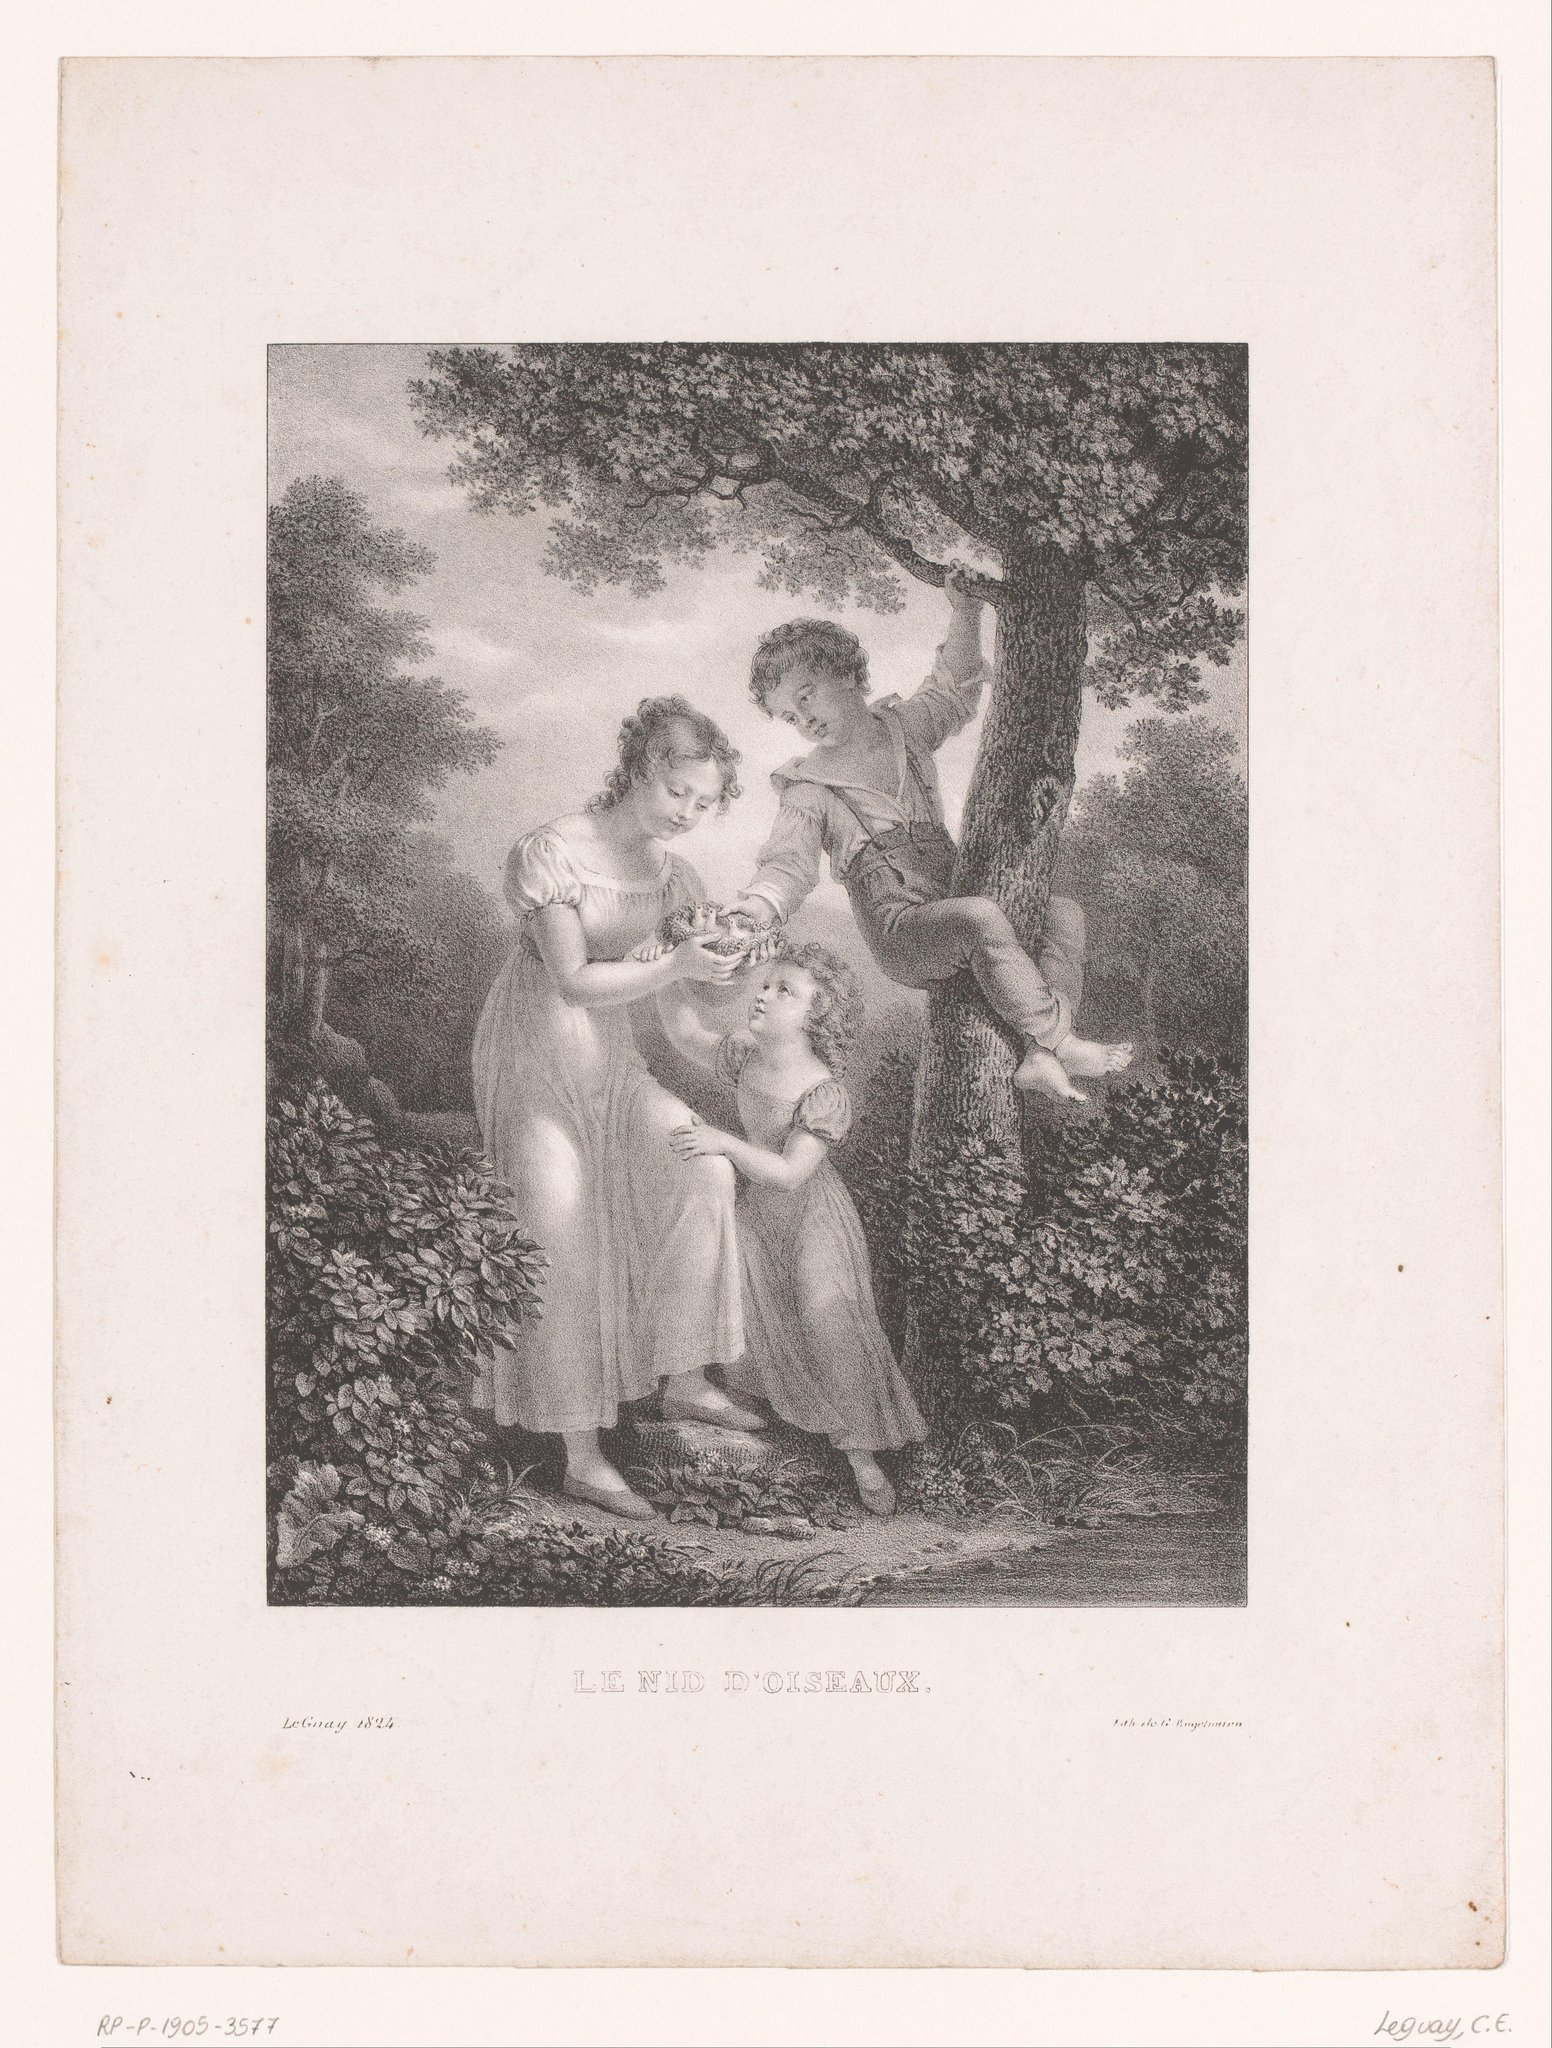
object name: print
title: Drie kinderen met een vogelnest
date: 1824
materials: paper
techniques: lithograph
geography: paris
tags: child robbing bird's nests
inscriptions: collector's mark: Lugt 2228a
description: Prent gebruikt voor: L'Album lithographique de 1825.